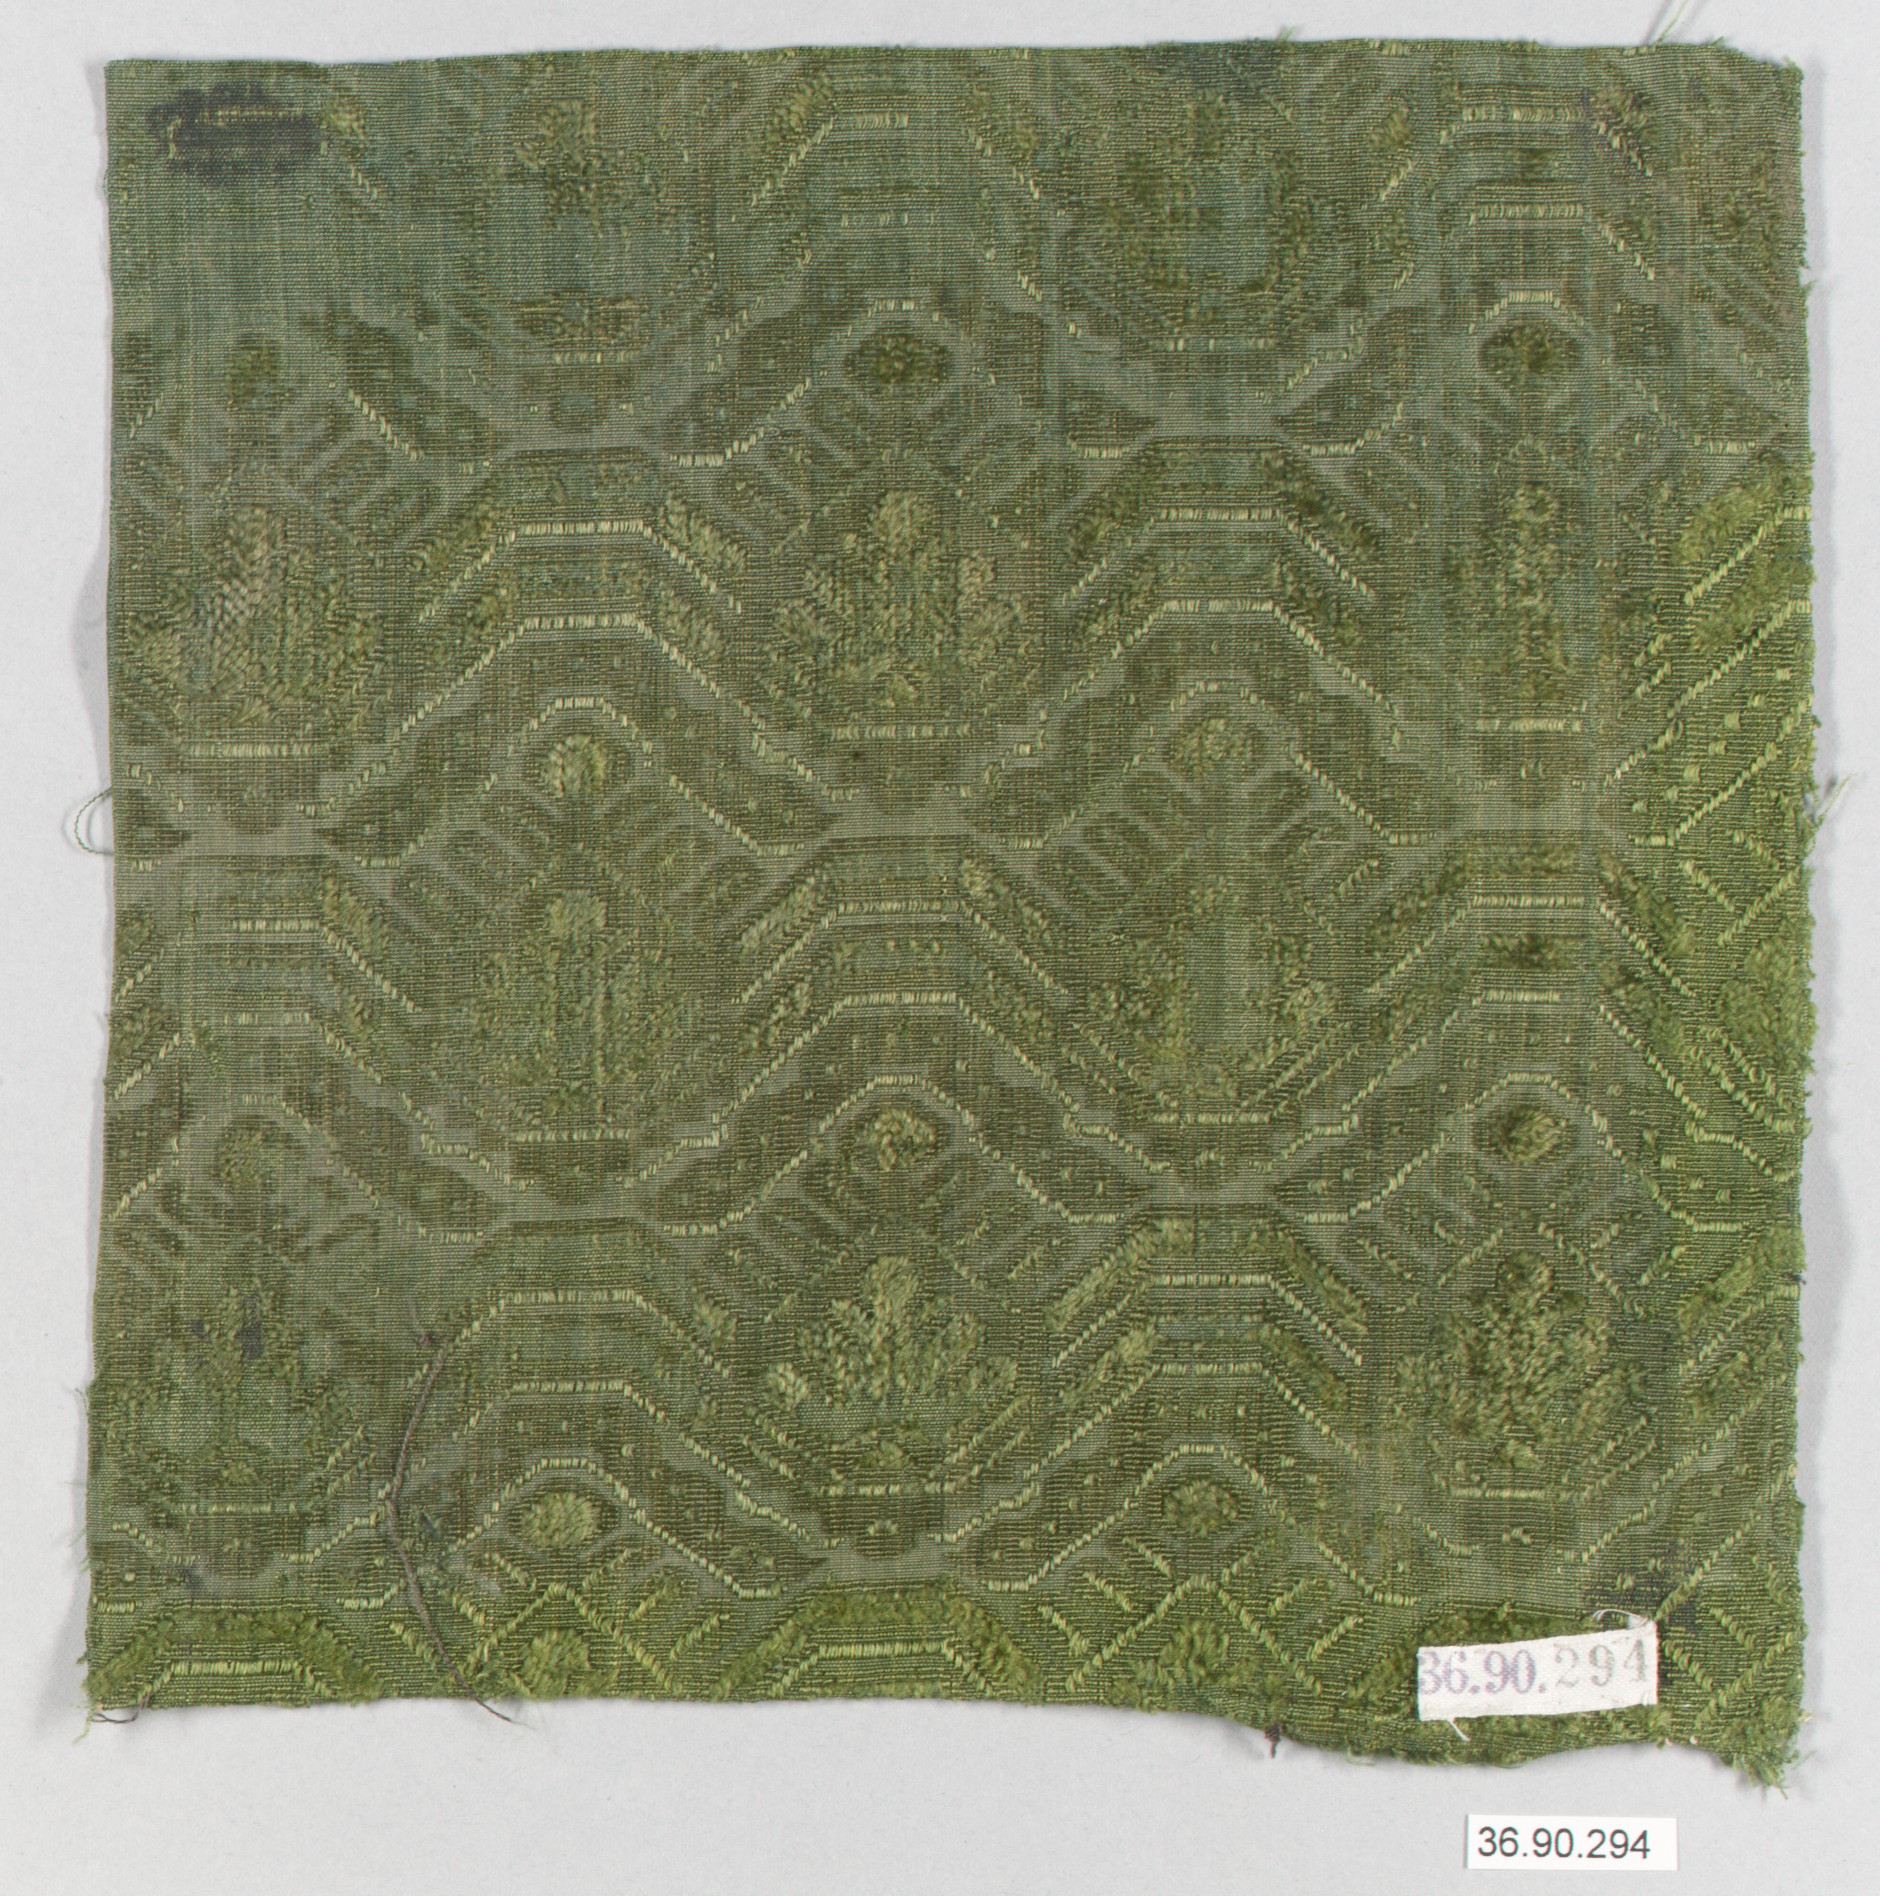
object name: piece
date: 1501-1700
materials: silk